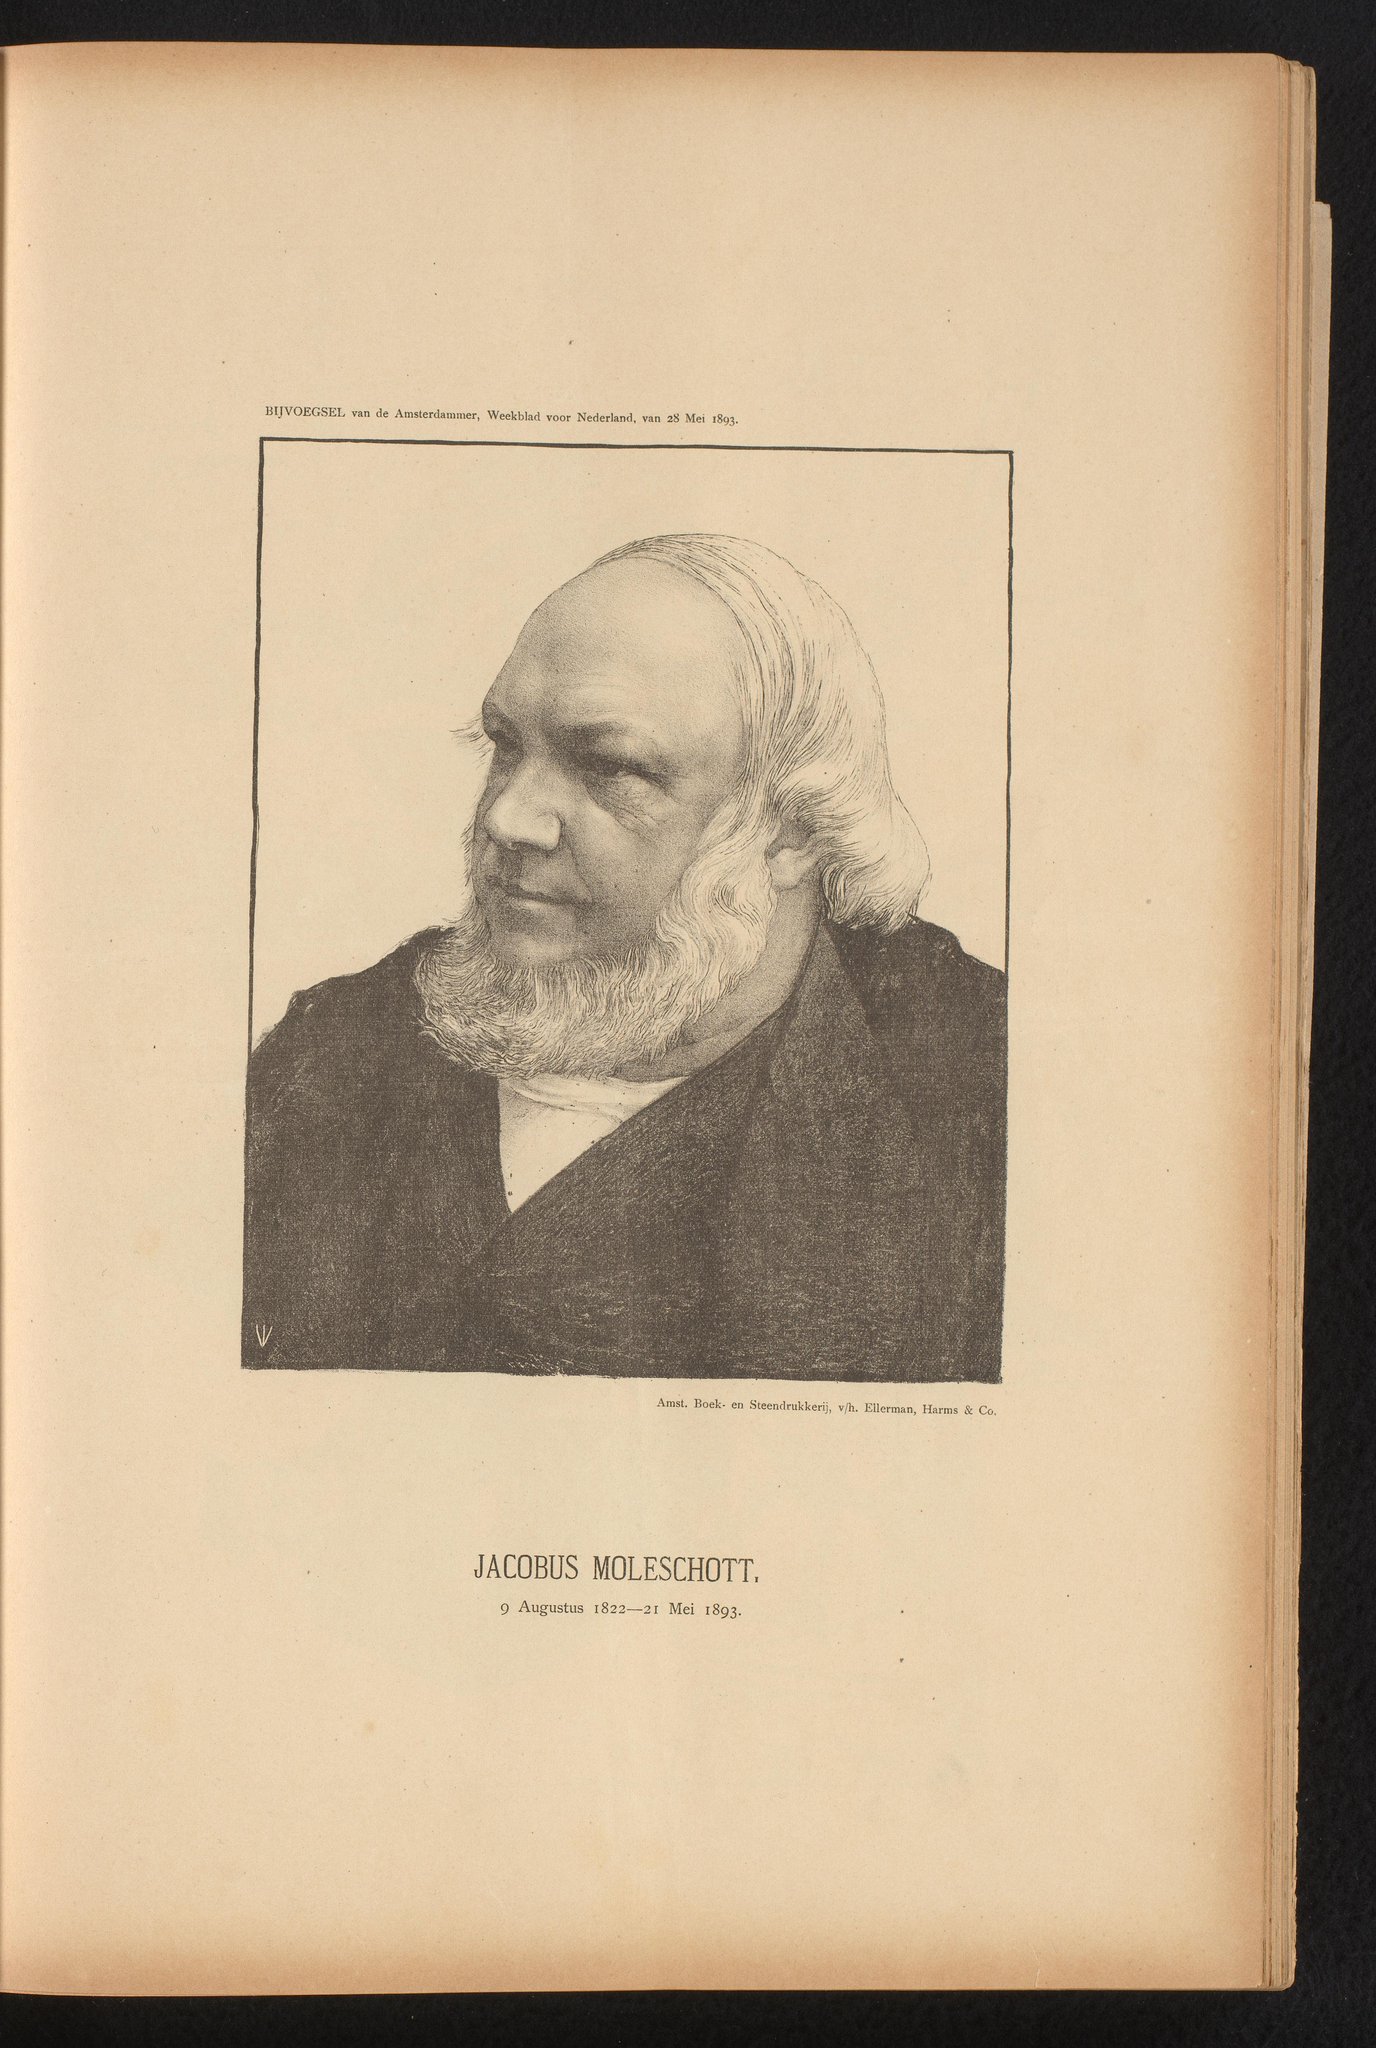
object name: print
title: Jacobus Moleschott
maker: jan veth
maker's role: designer, draughtsman, painter, print maker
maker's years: 1864-1925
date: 1893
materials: paper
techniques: lithograph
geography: amsterdam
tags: den bosch, rome, historical persons, professor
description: Portret van de arts en hoogleraar Jacobus Moleschott, overleden 21 mei 1893. In de serie 'Bekende Tijdgenooten', ongenummerd.